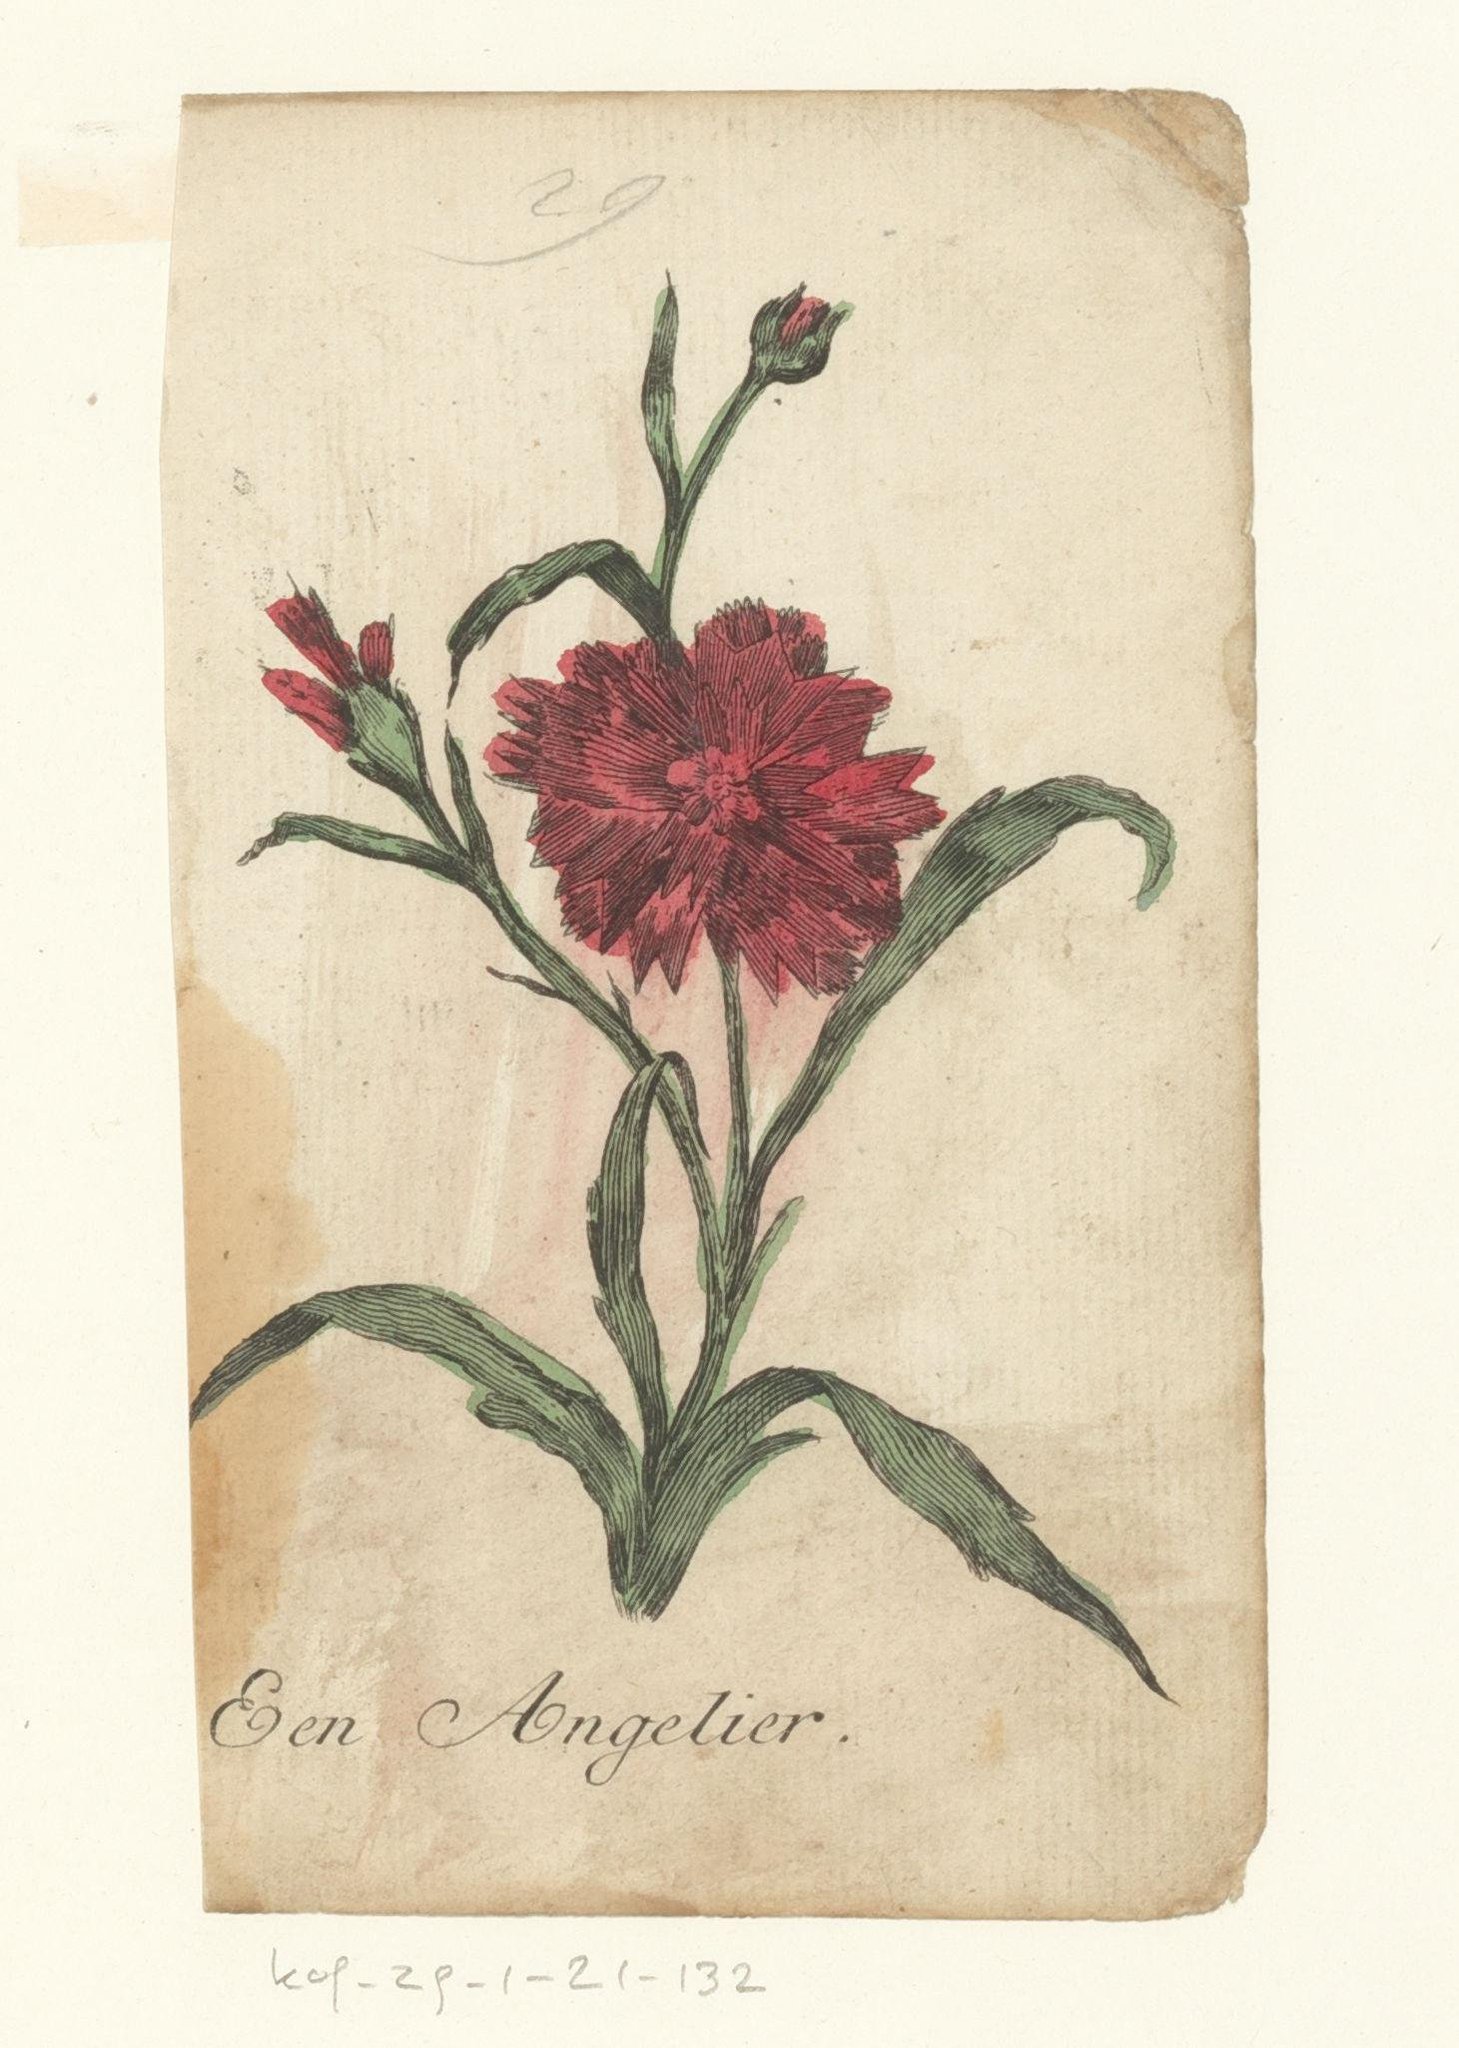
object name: print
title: Een Angelier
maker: Anonymous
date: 1821-1829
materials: paper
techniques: engraving, etching, hand coloring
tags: flowers: carnation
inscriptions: collector's mark: Lugt 1641, collector's mark: Lugt 1641a, stamp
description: Prent waarschijnlijk uit: Hans Beuling, of St. Nicolaas- Nieuwejaars- Vastenavond- en kermisvermaak. Voor kinderen. Rotterdam: B. Schuurling, s.a [1821-1829]. Volgens de Atlas van Stolk ook gebruikt in: De nieuwe toverlantaarn. Amsterdam: s.n., 1797.